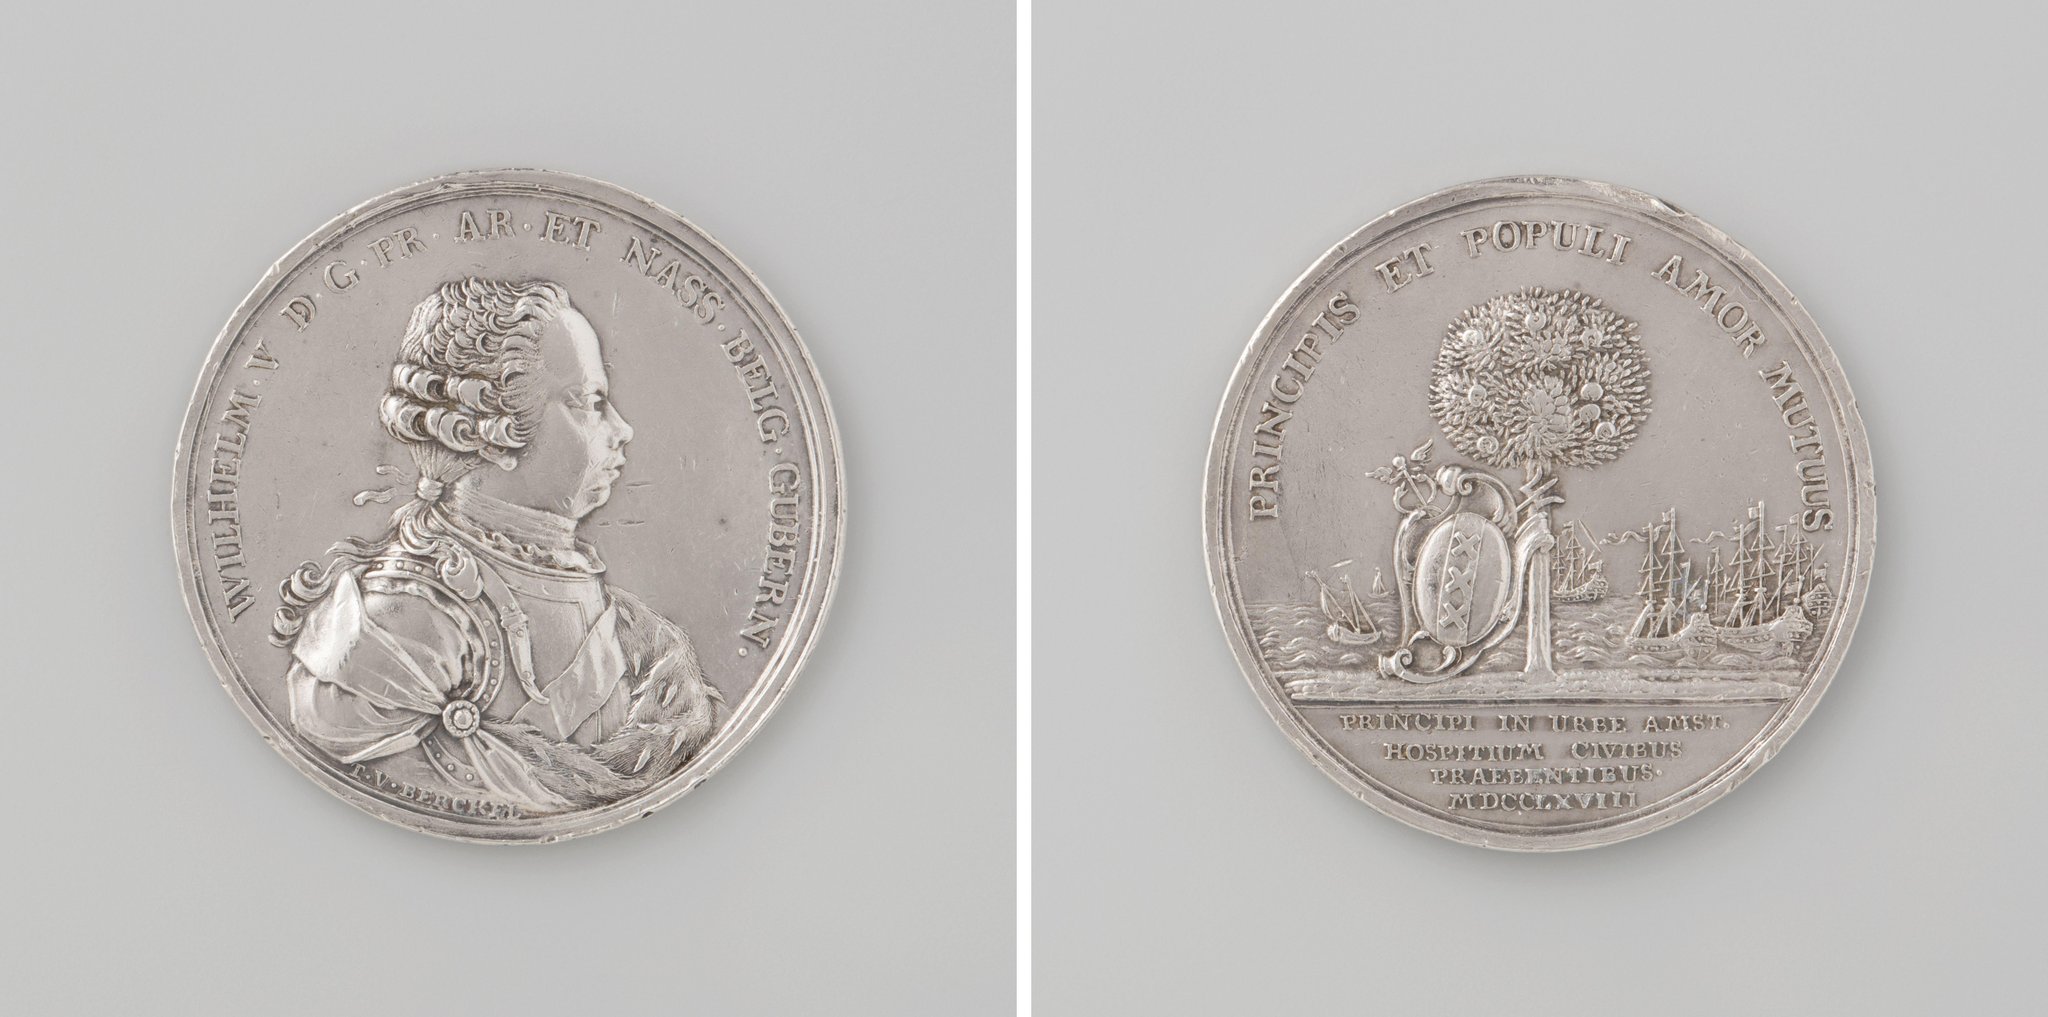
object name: history medal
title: Verblijf van Willem V en Wilhelmina van Pruisen te Amsterdam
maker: theodorus victor van berckel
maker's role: mintmaster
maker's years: 1739-1808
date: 1768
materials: silver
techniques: striking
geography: rotterdam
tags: william v (prince of orange), berlin, painter, draughtsman, wilhelmina of prussia (princess of orange), amsterdam